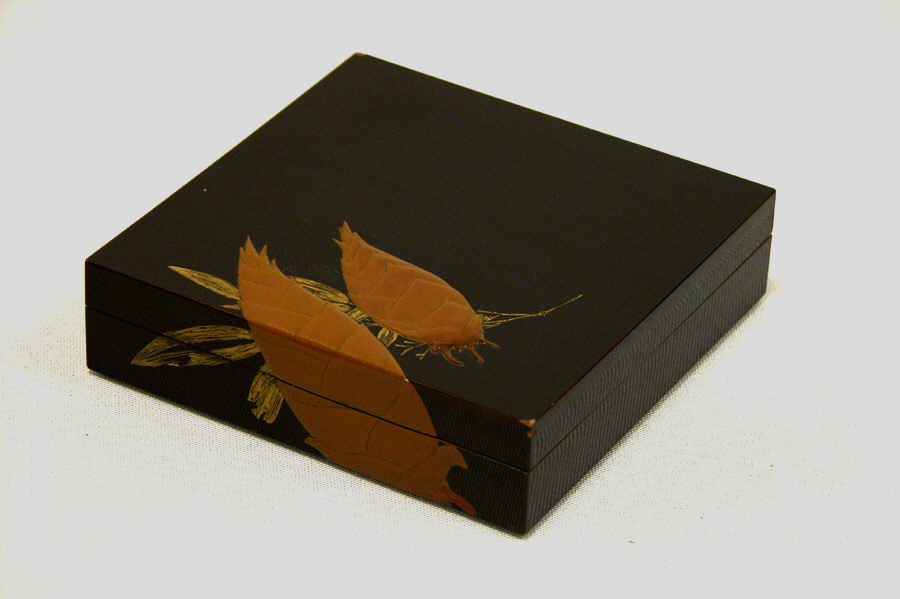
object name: box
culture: japanese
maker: shibata zeshin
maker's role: artist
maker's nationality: japanese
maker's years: 1807-1891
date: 1801-1900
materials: lacquer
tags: leaves